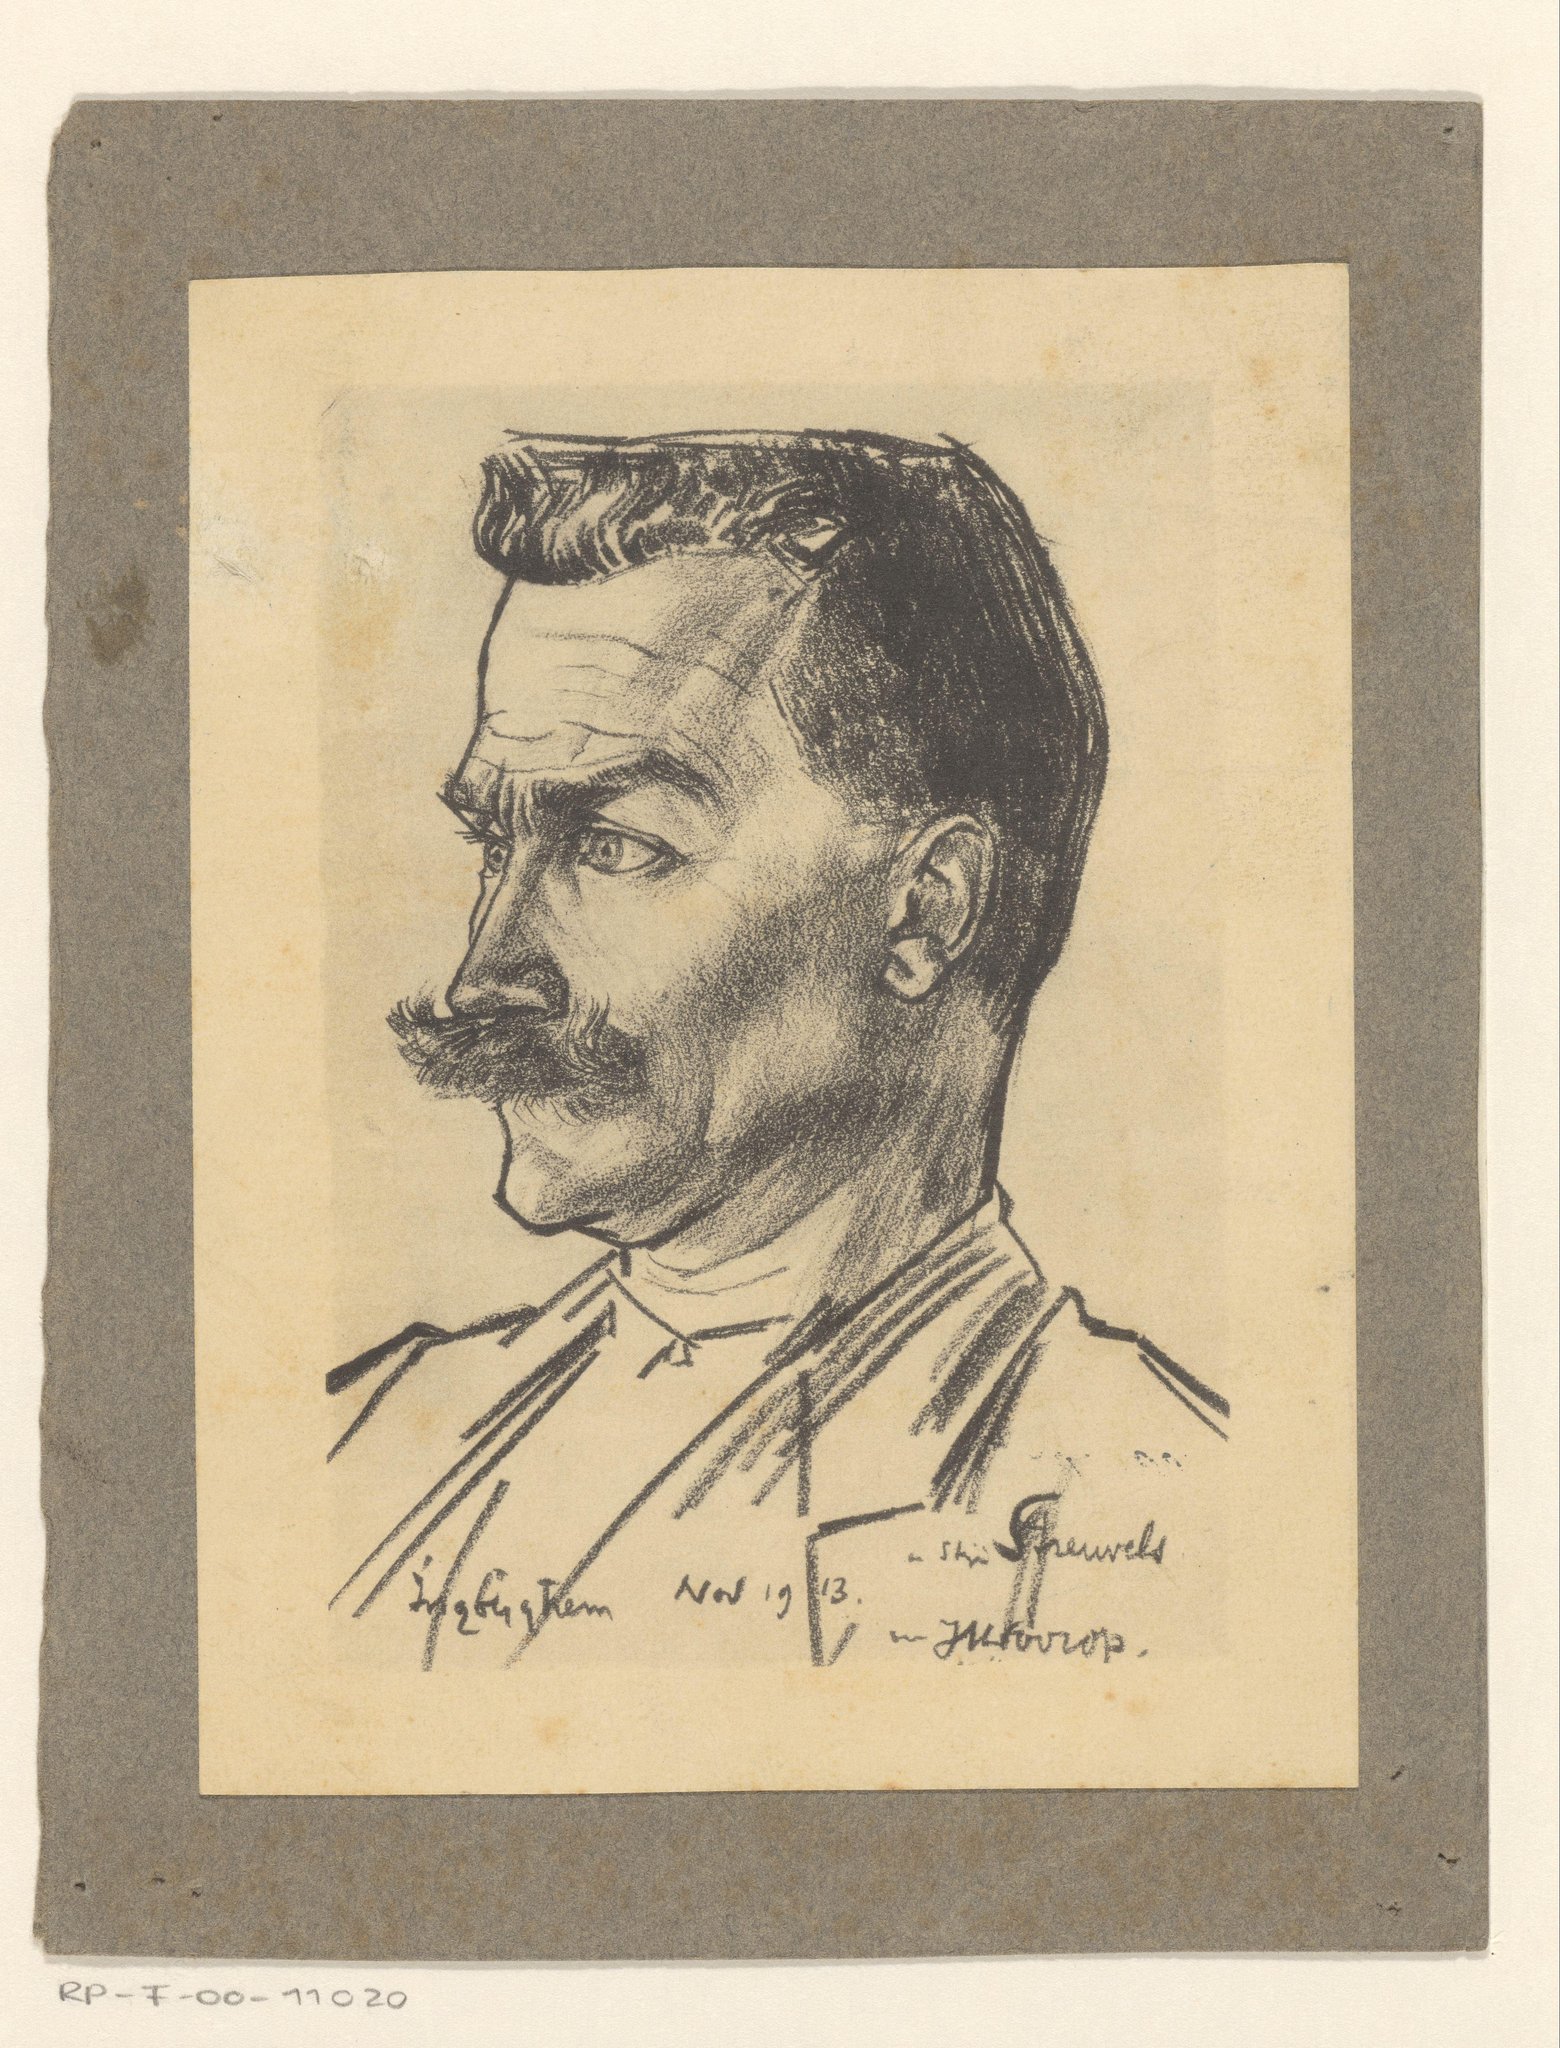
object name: photomechanical print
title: Reproductie van een getekend portret van Stijn Streuvels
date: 1911-1913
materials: cardboard, paper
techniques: photograph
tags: stijn streuvels, portrait of a writer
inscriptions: collector's mark: Lugt 2228a